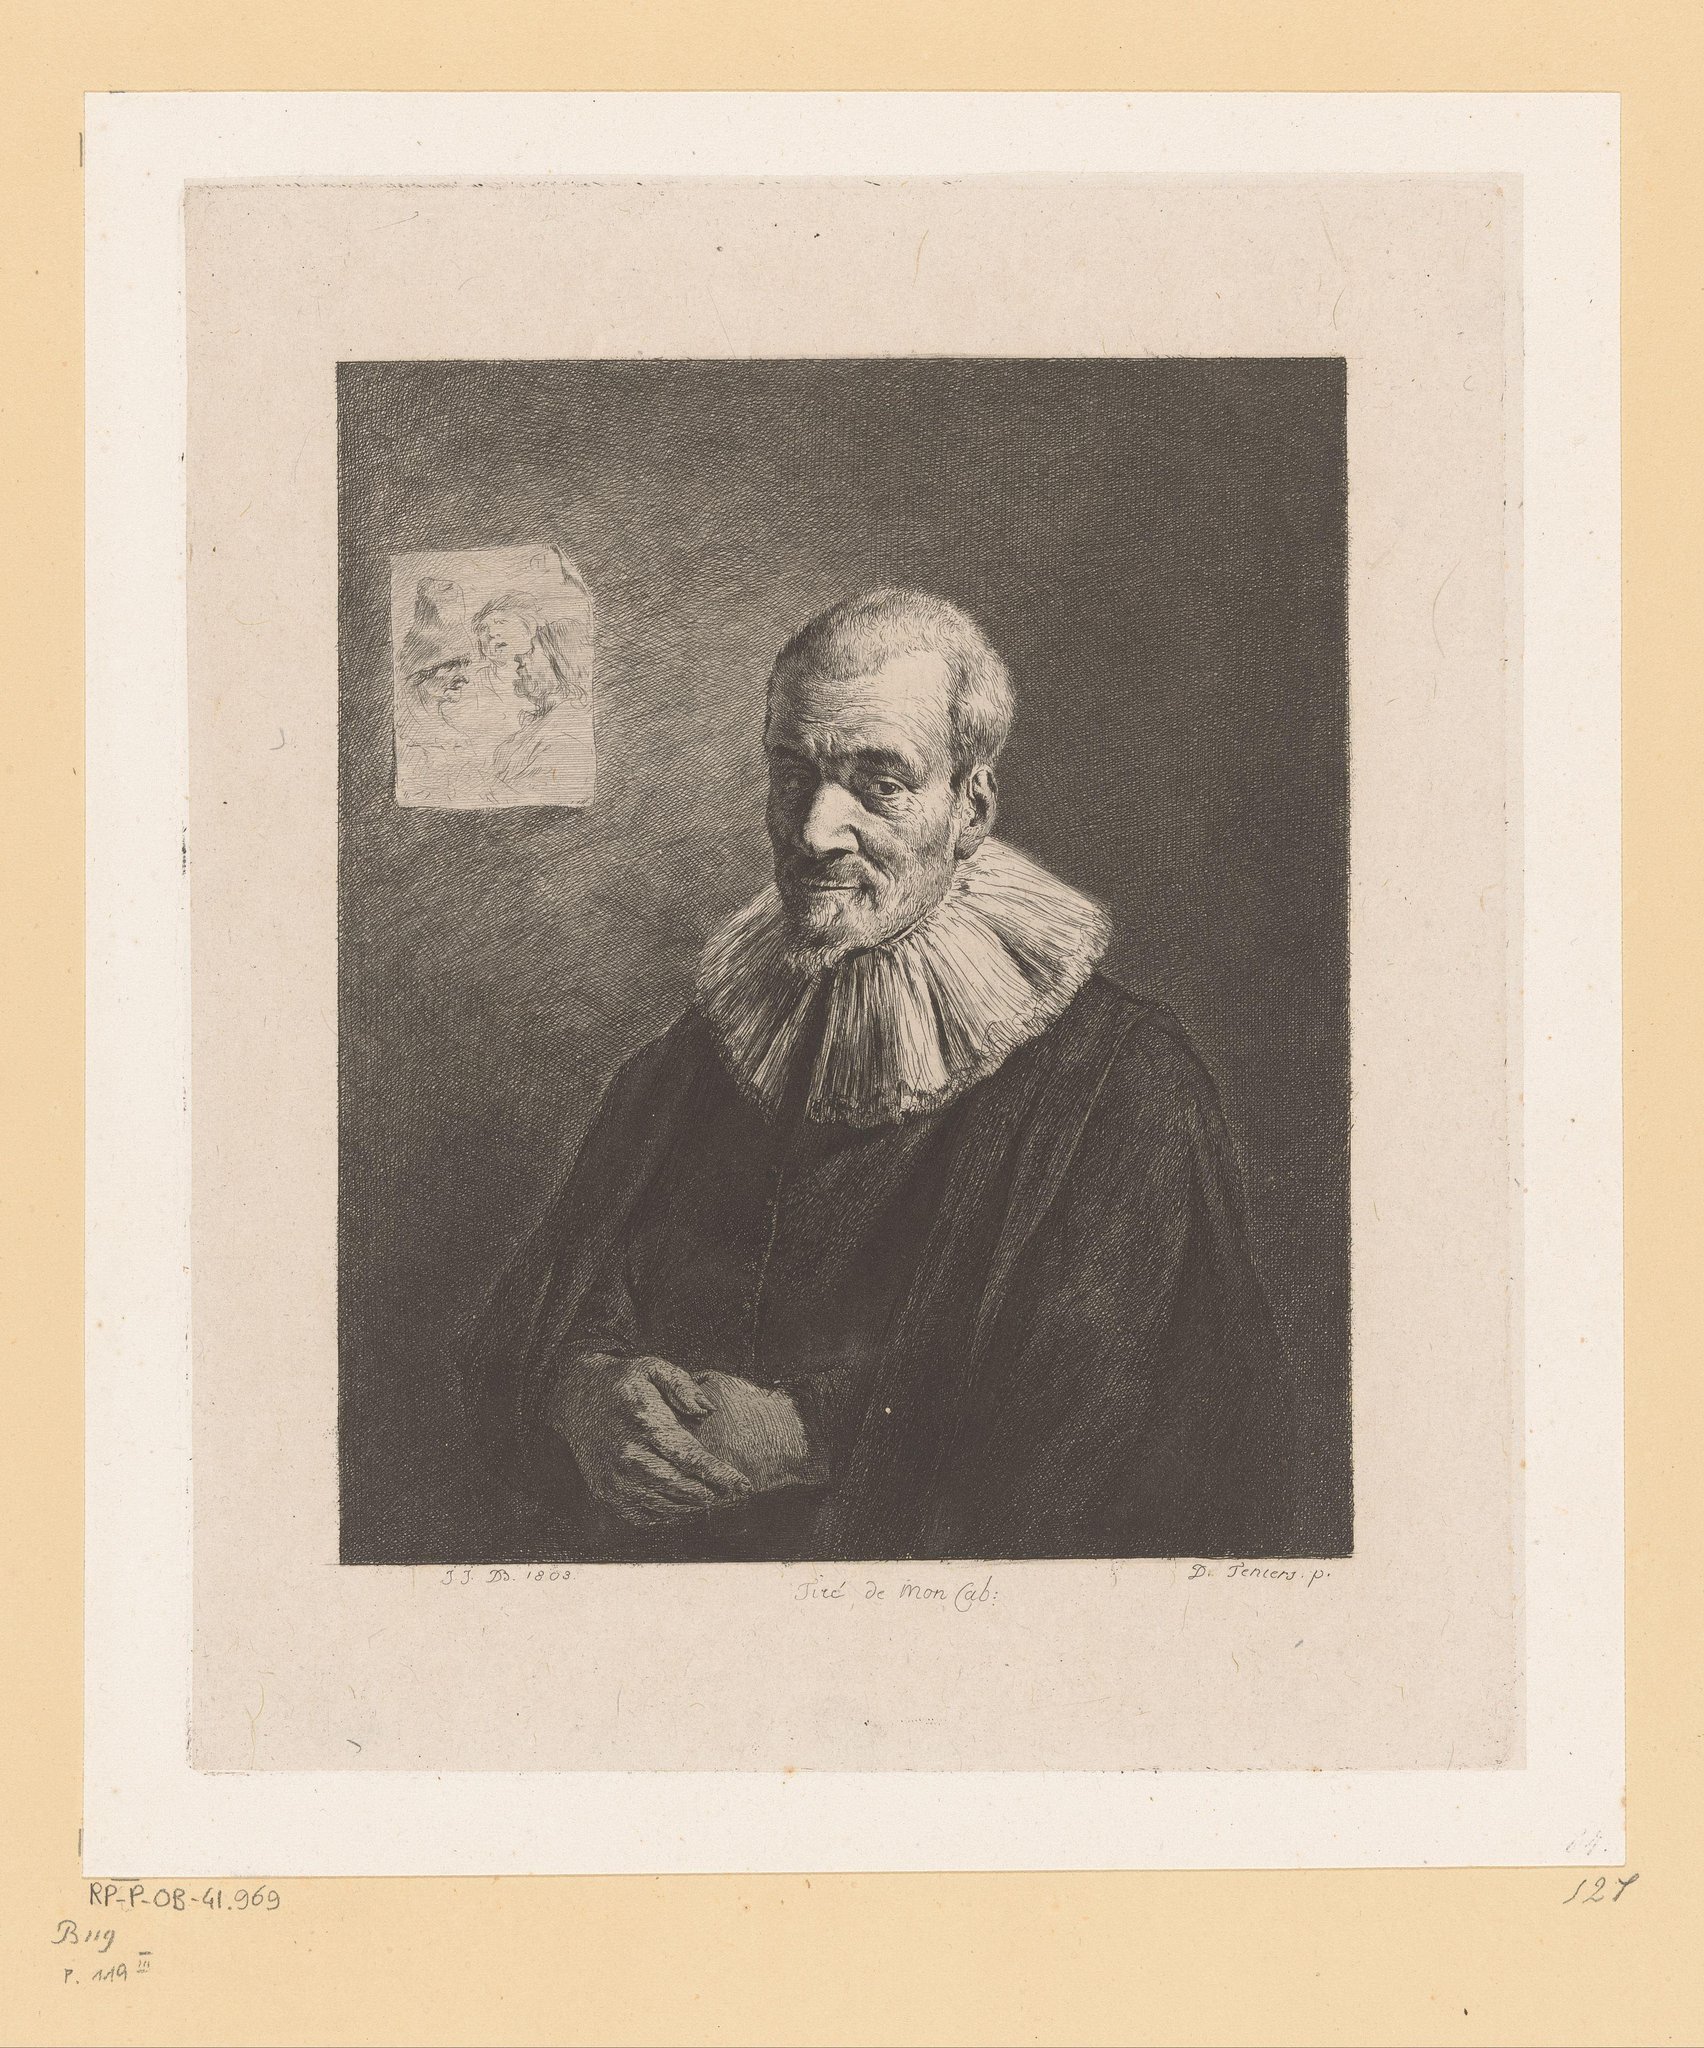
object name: print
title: Portret van een onbekende man met witte kraag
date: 1803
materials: paper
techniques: drypoint, etching, roulette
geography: france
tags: historical persons (portraits and scenes from the life)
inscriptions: collector's mark: Lugt 12